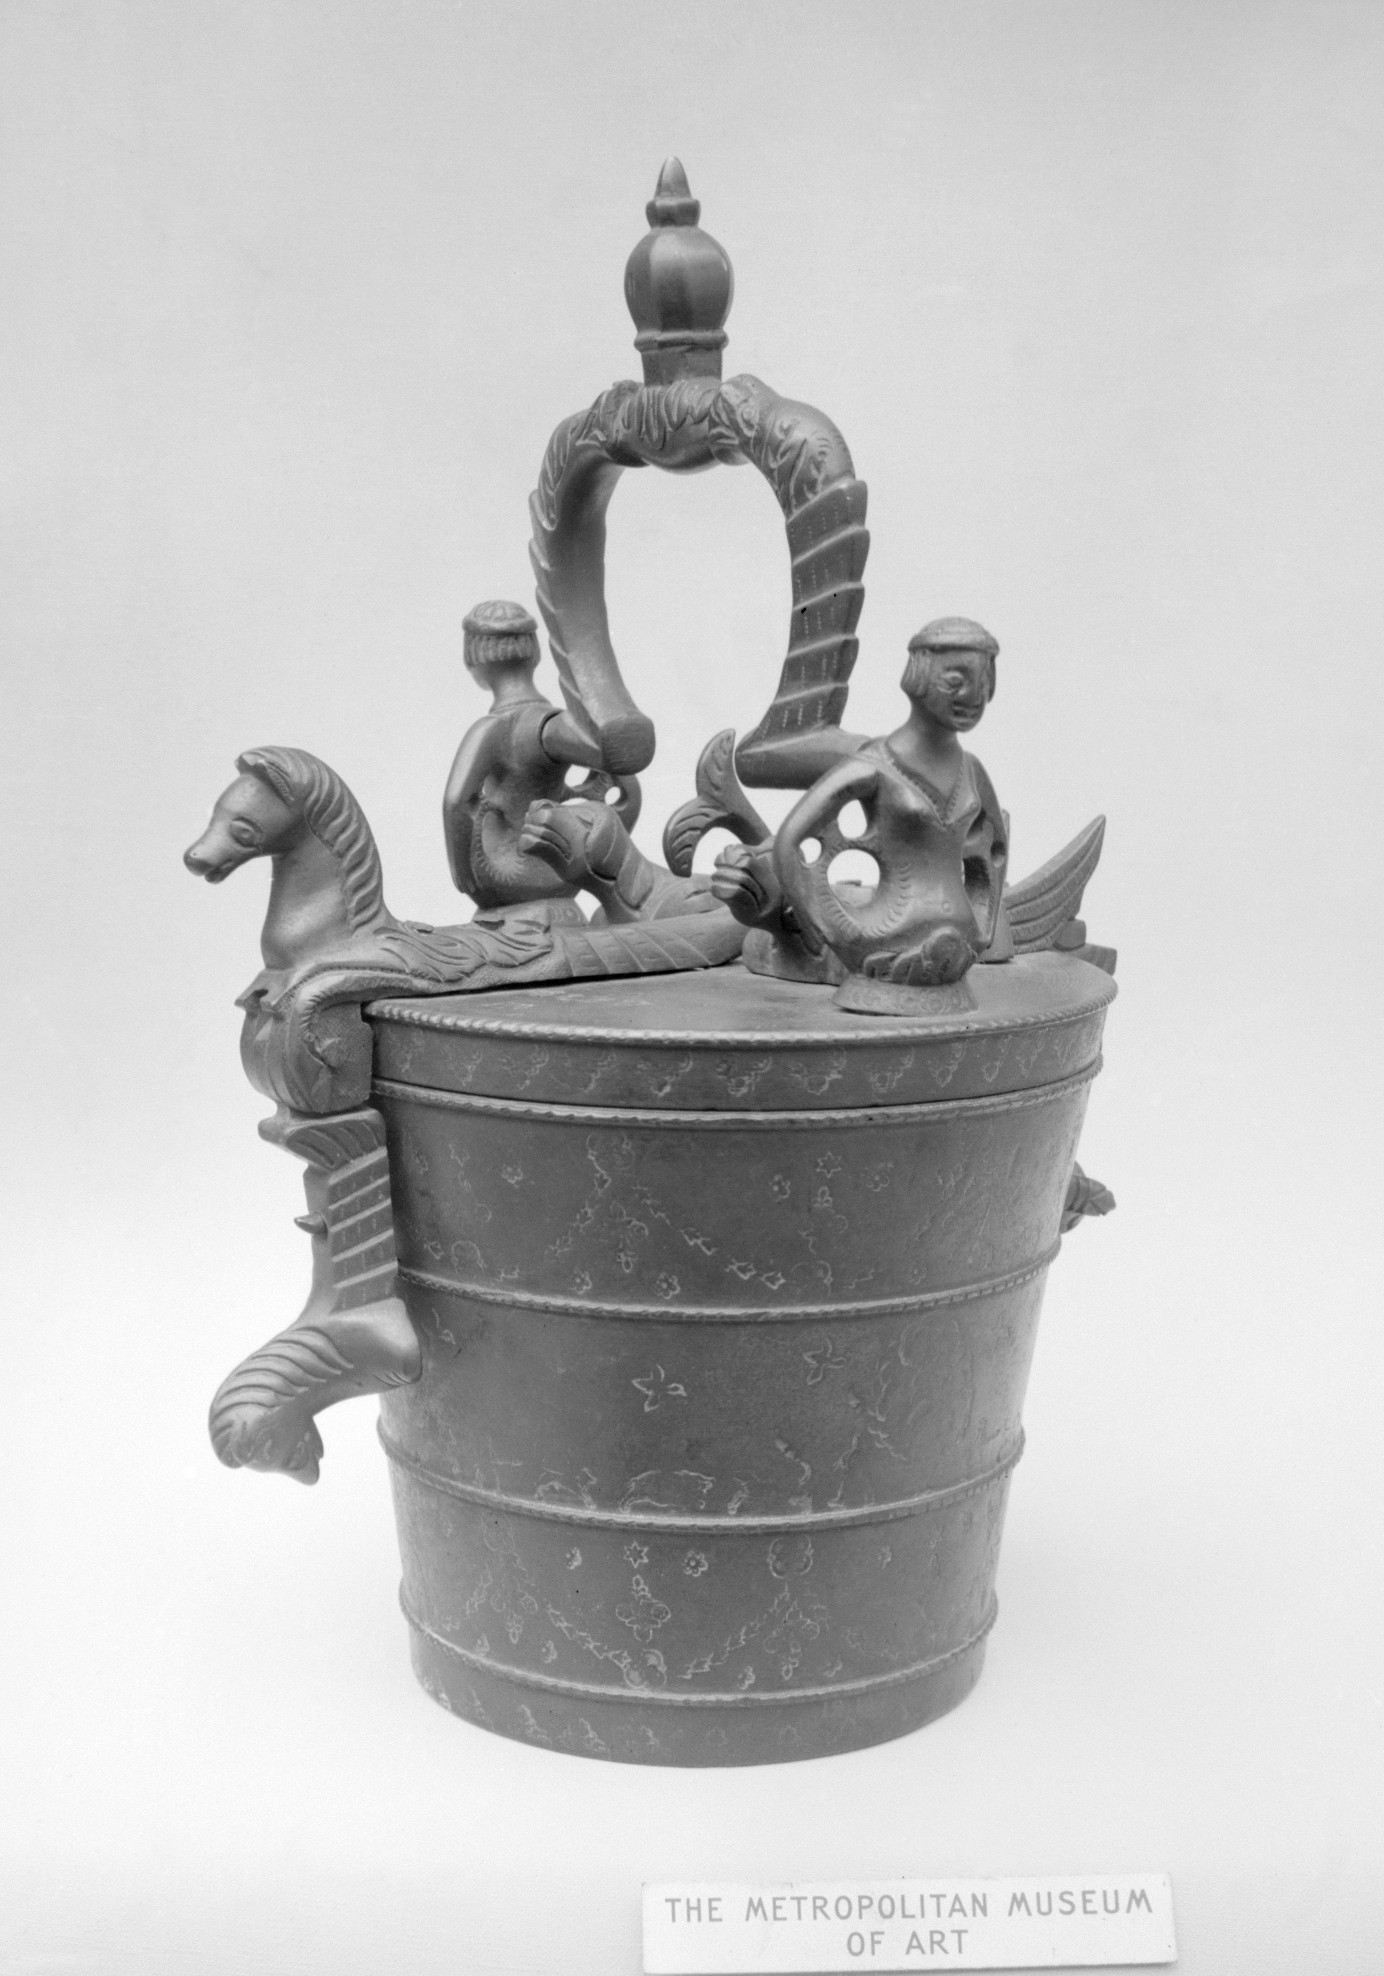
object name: weight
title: Set of weights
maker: andreas ziegengeist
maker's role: maker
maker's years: 1681-1706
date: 1667-1733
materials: brass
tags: men,horses